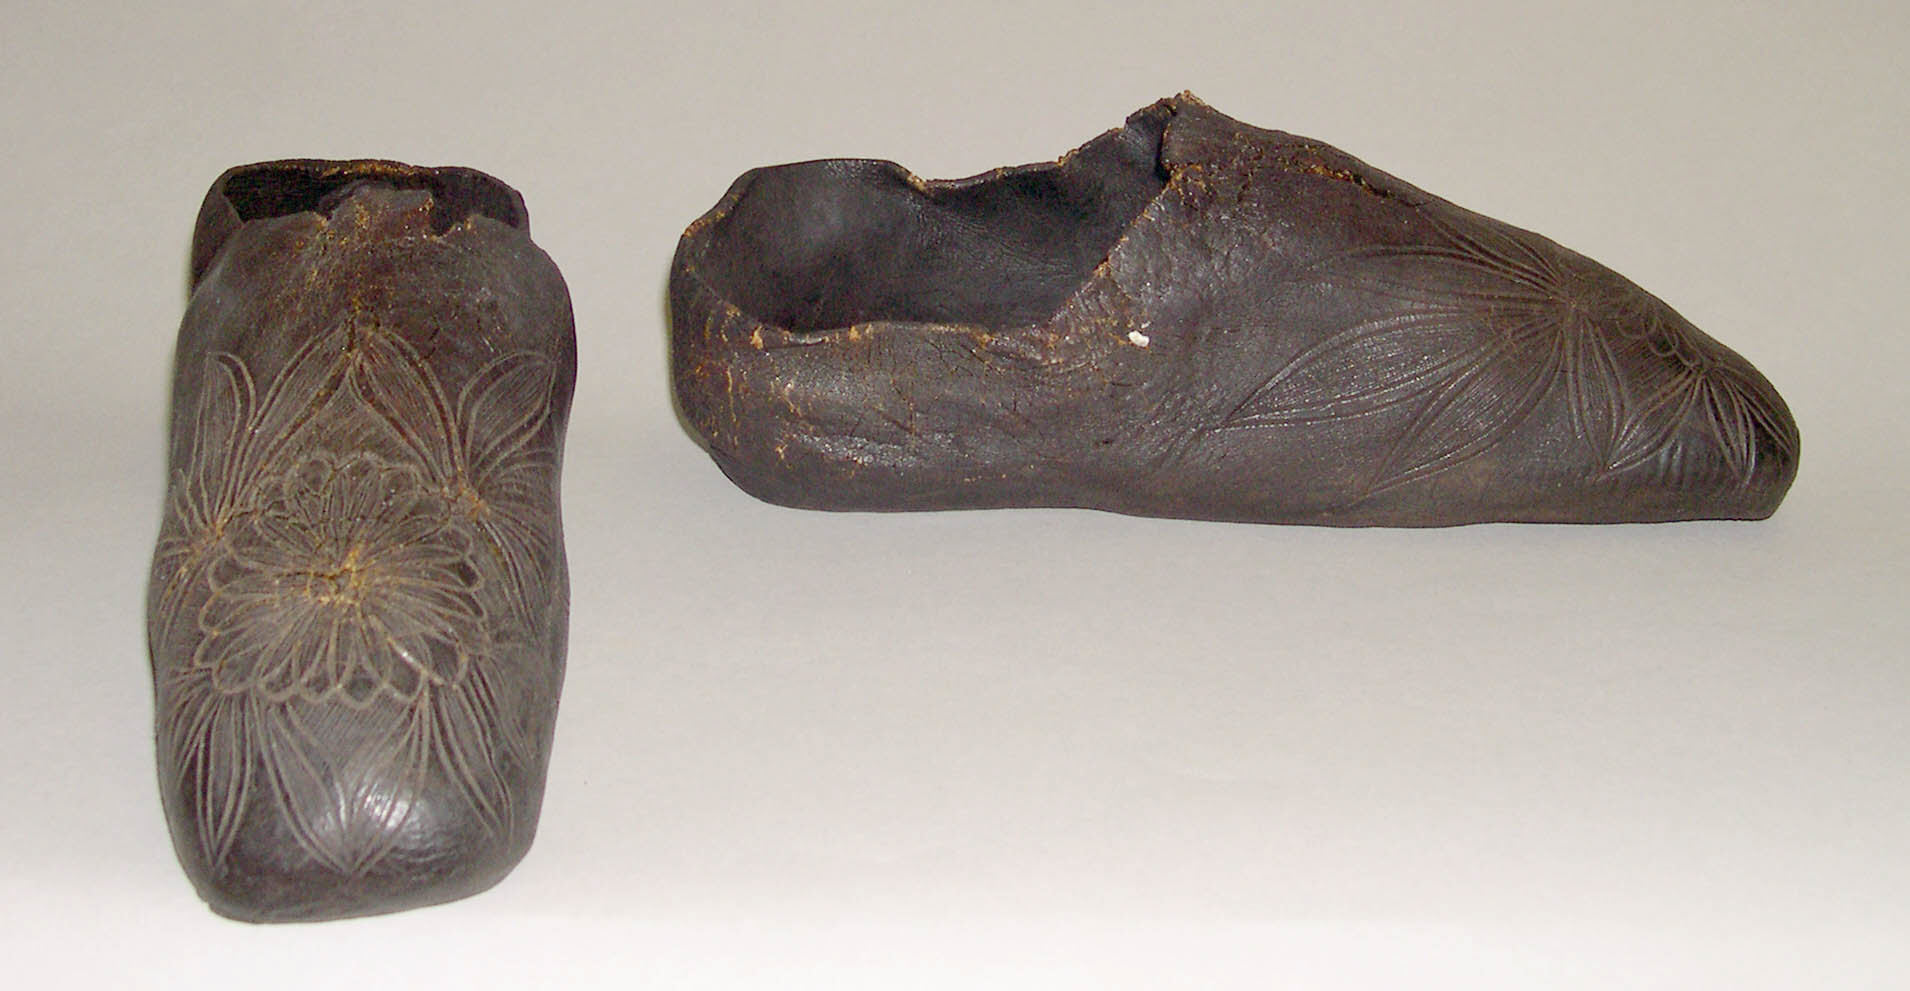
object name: overshoe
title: Overshoes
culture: american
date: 1830